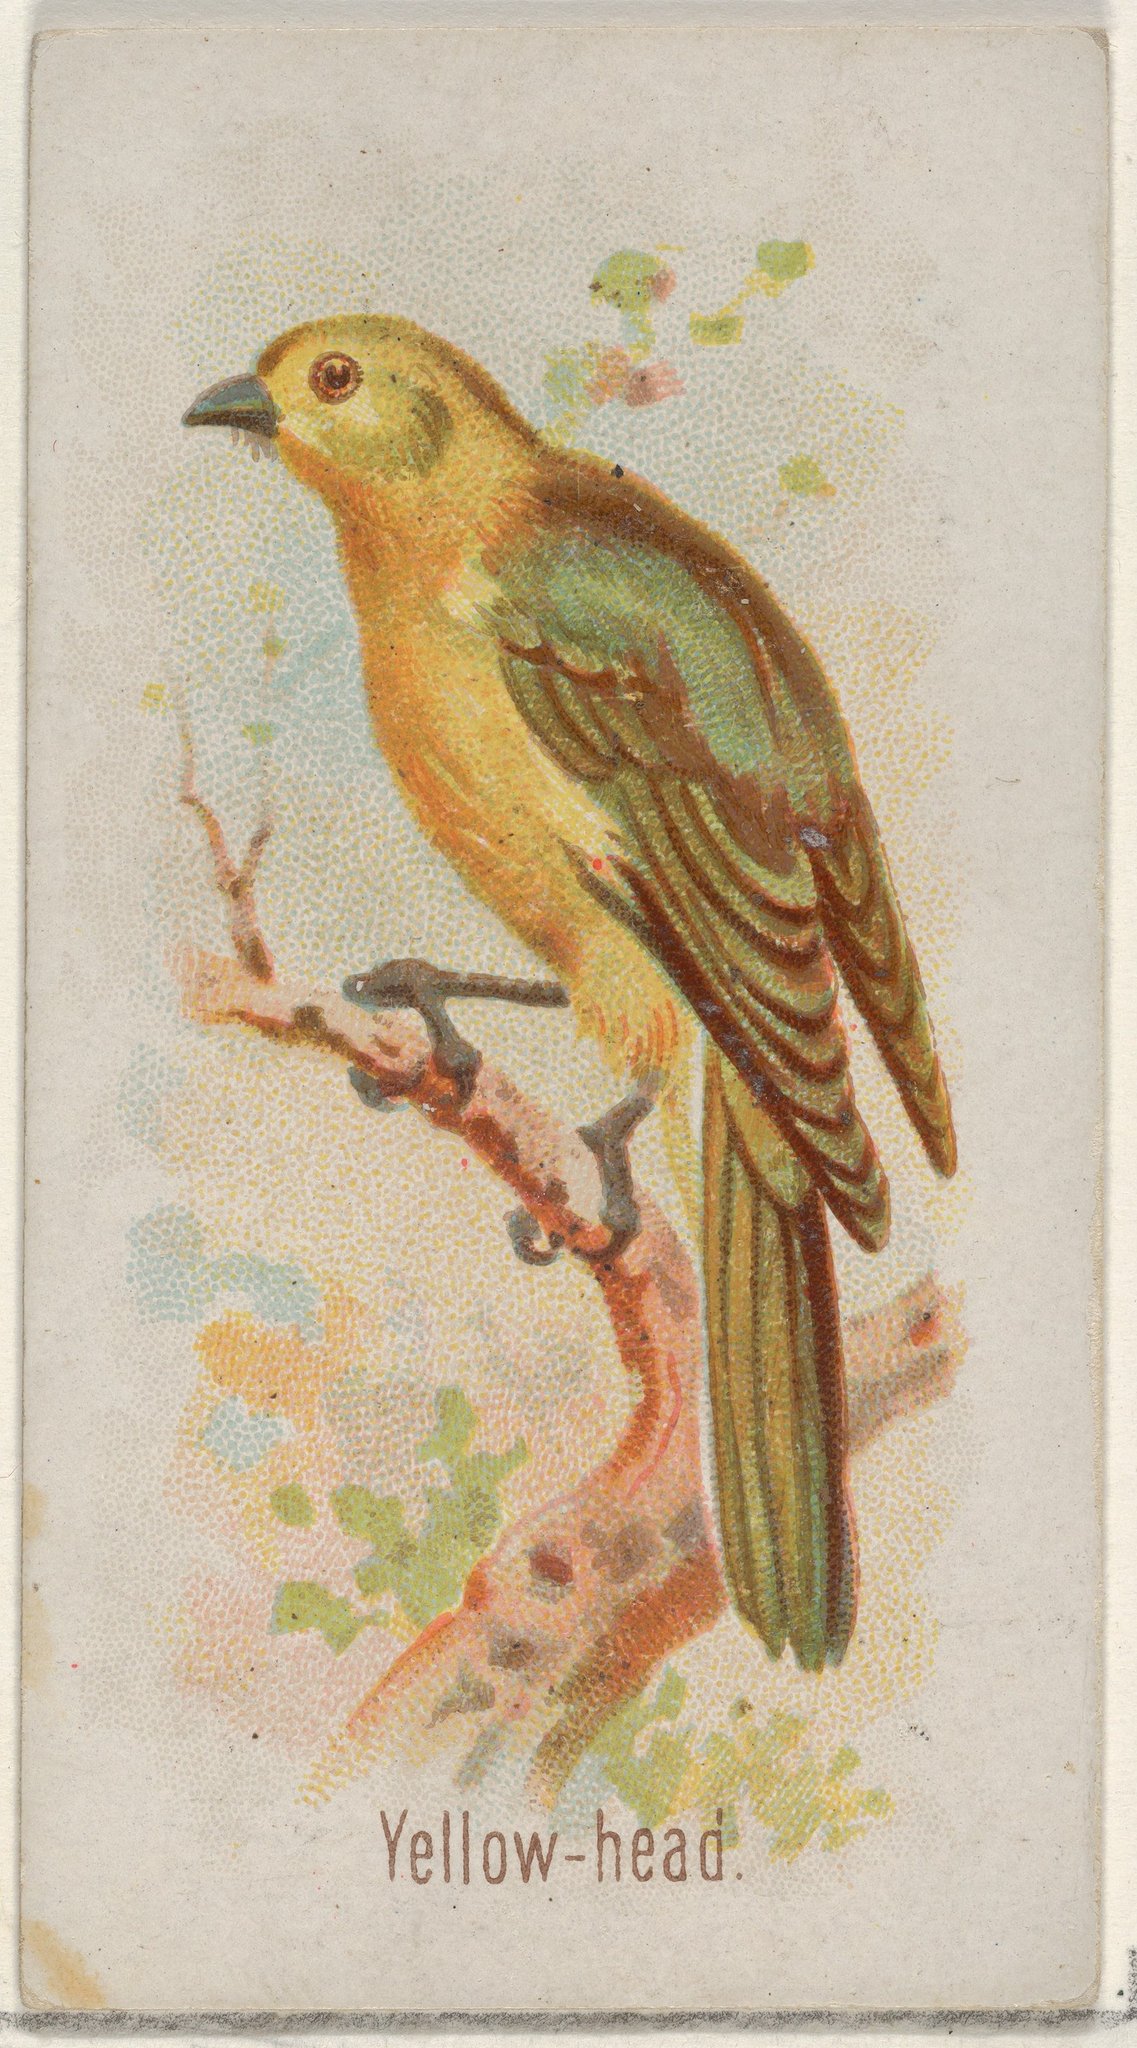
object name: print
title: Yellow-head, from the Song Birds of the World series (N23) for Allen & Ginter Cigarettes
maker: allen & ginter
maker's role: publisher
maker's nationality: american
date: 1890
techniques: color lithograph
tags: birds